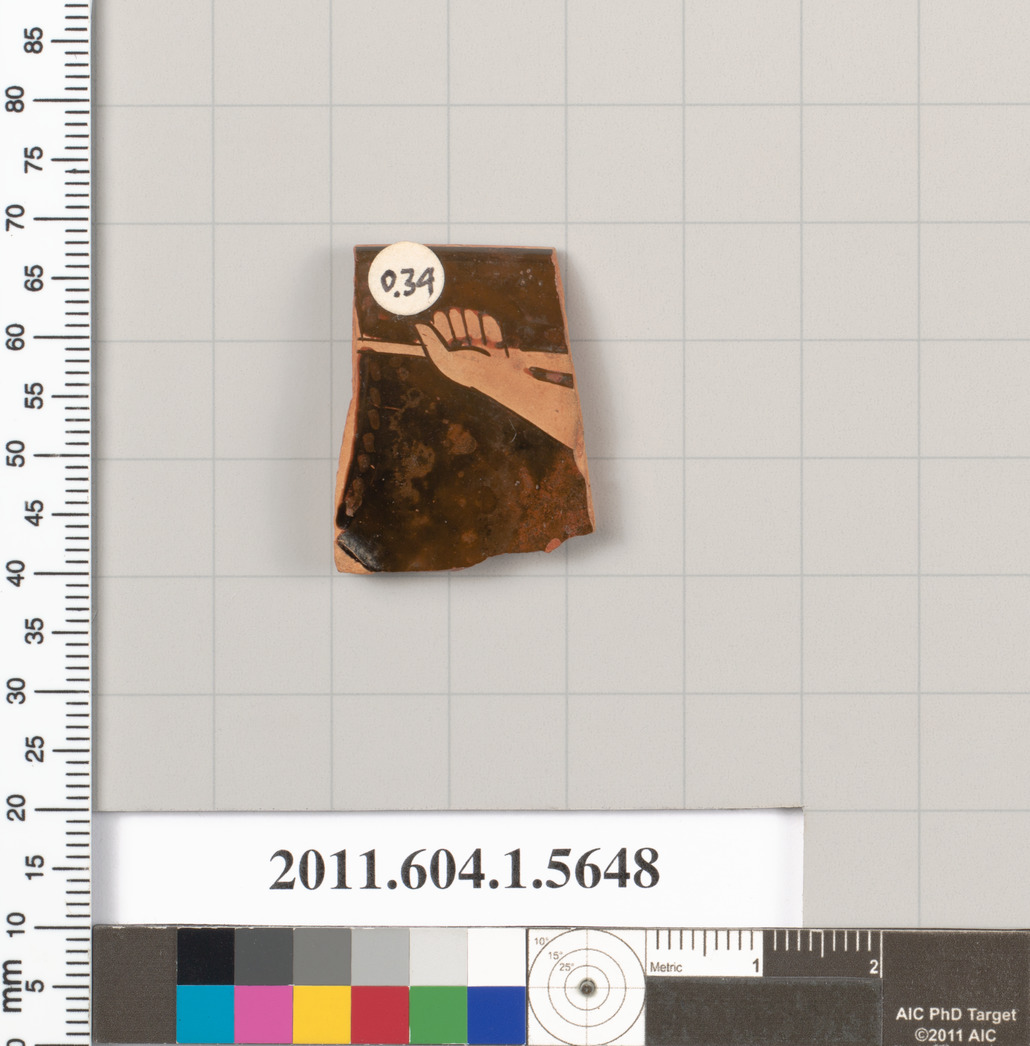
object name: kylix fragment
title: Terracotta rim fragment of a kylix (drinking cup)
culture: greek, attic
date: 500-480 BCE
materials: terracotta